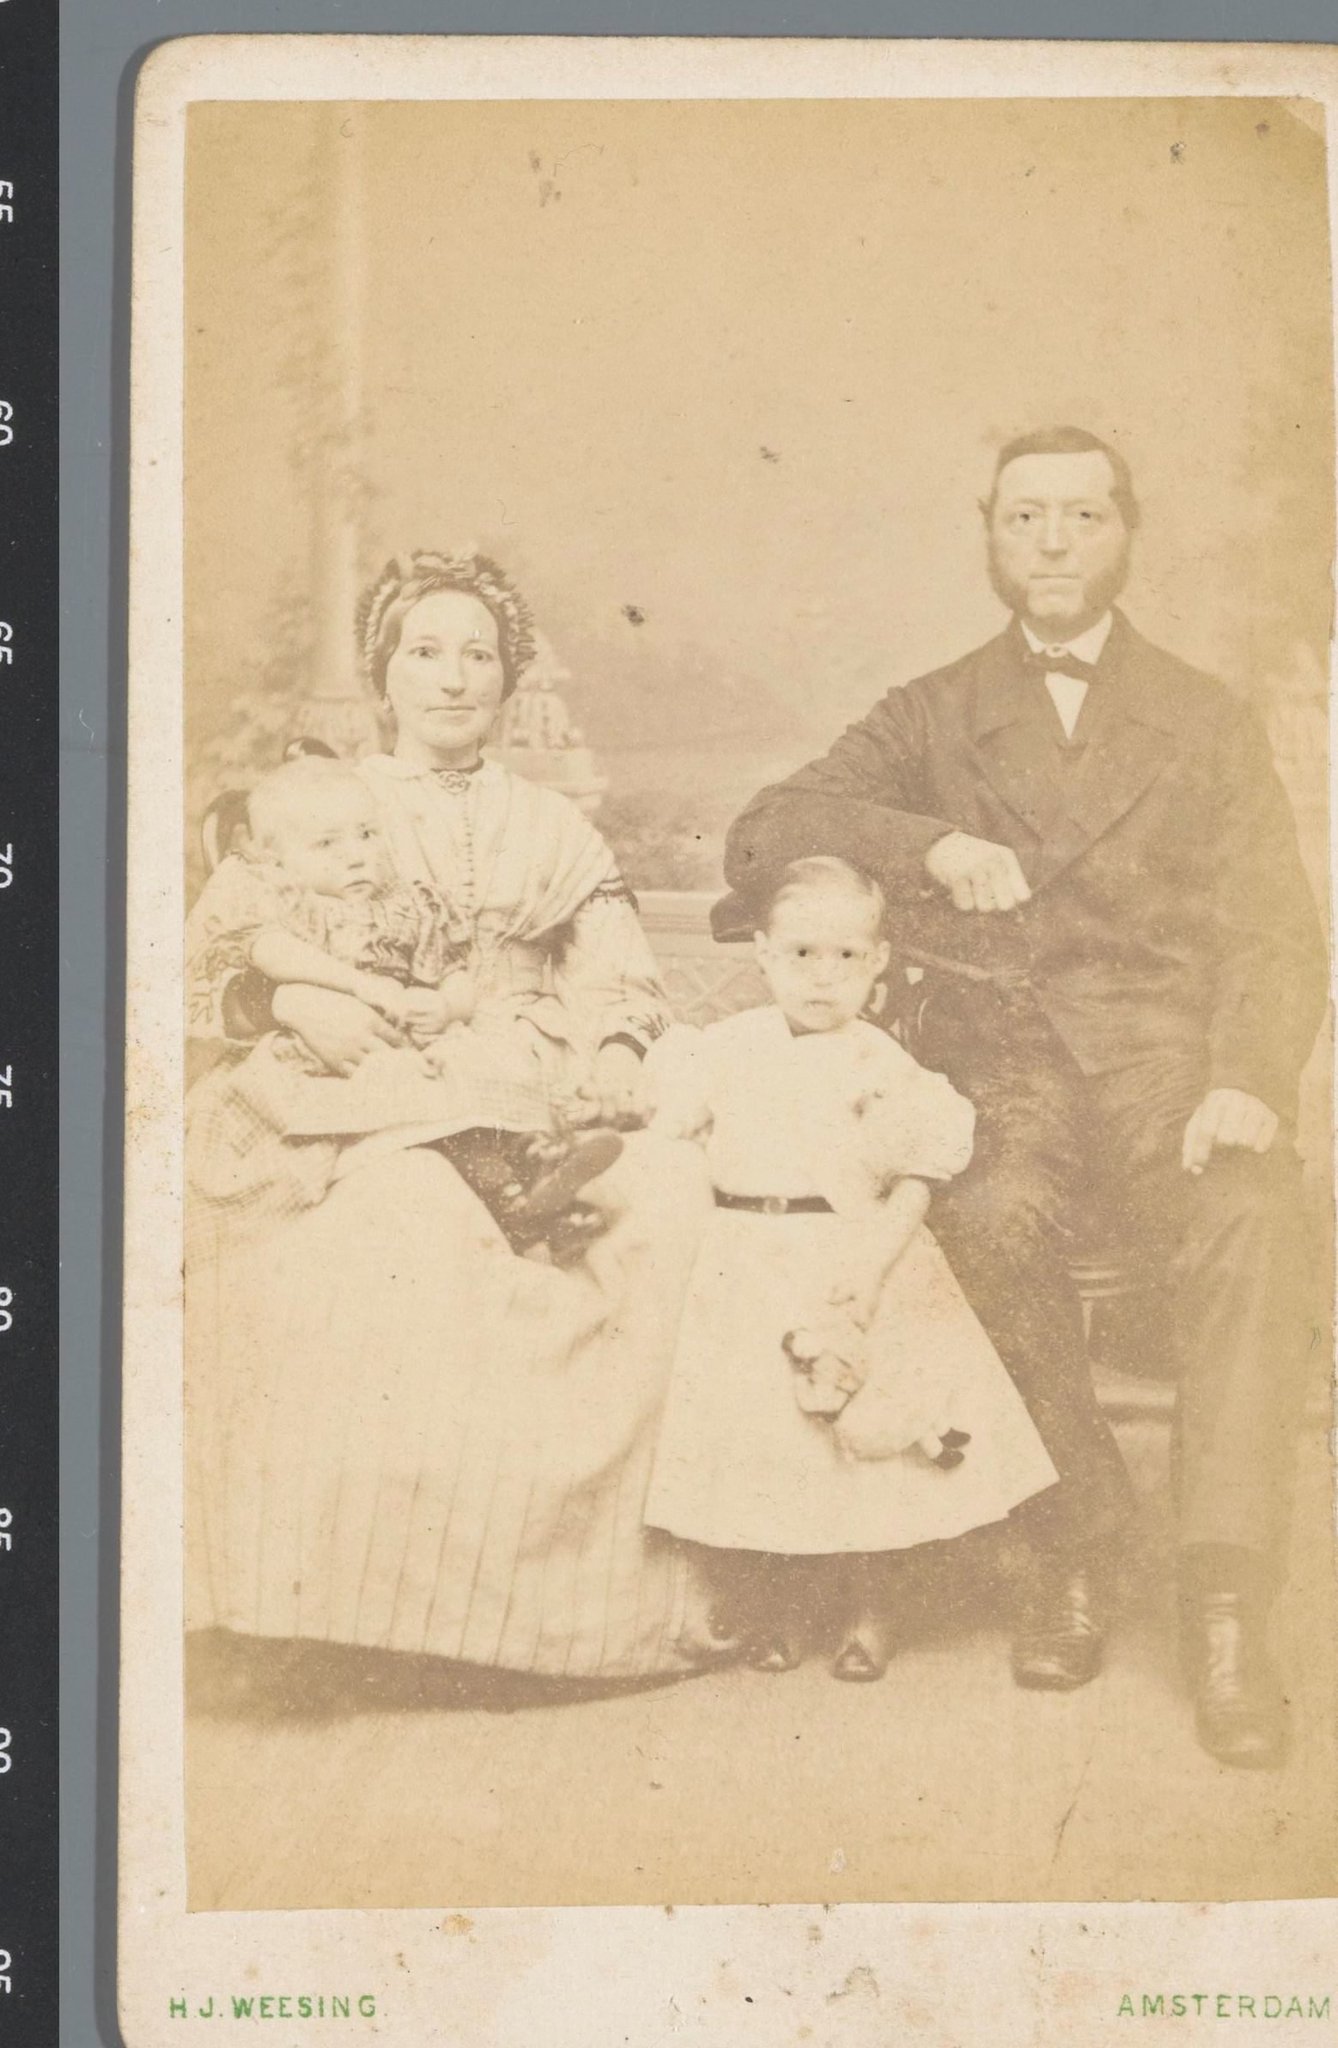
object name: photograph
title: Groepsportret van een onbekende man, vrouw en twee kinderen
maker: hermanus jodocus weesing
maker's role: fotograaf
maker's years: 1844-1910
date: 1868-1900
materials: cardboard, paper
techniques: albumen print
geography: amsterdam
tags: family life, anonymous historical person portrayed, amsterdam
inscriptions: inscription: ‘Photographisch/ Atelier/ van/ H.J. Weesing/ Binnen Brouwerstraat T.T. 220./ te/ Amsterdam’, inscription: ‘H.J. Weesing Amsterdam’